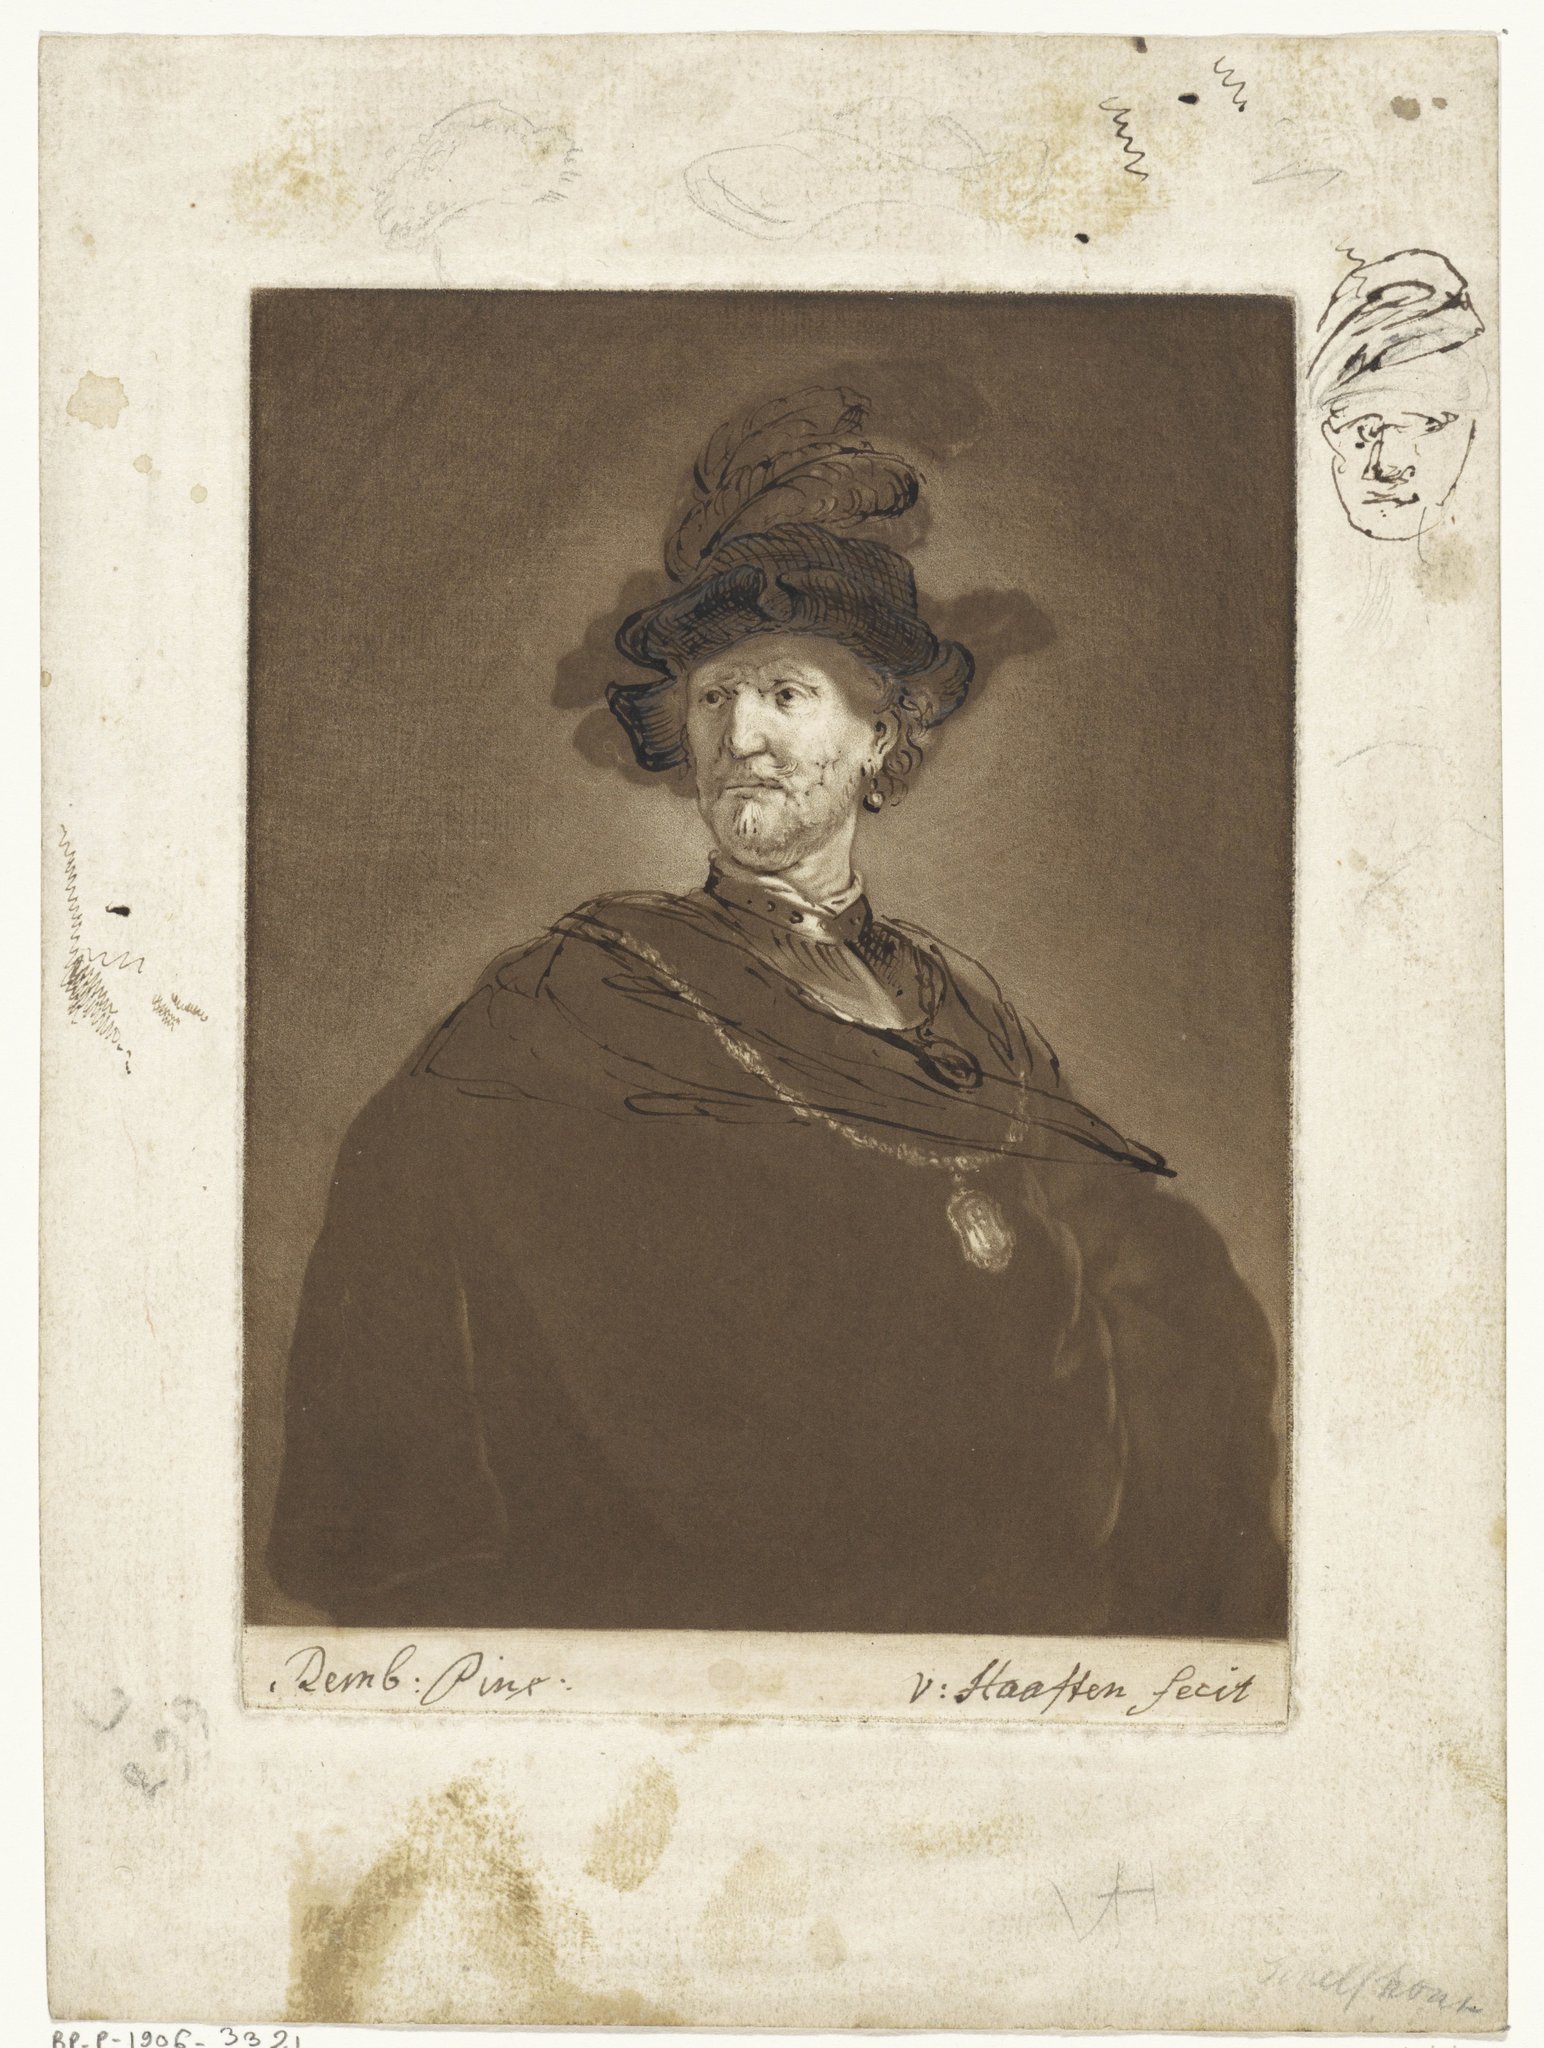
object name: print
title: Portret van een man, mogelijk Harmen Gerritsz. van Rijn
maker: rembrandt van rijn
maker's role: draughtsman, painter, print maker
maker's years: 1606-1669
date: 1673-1715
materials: paper, pencil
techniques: printing, pen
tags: head-gear: hat (+ men's clothes)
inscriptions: collector's mark: Lugt 2228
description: Een man, mogelijk Rembrandts vader, Harmen Gerritsz van Rijn. Hij draagt een gevederde baret en een halsketen.